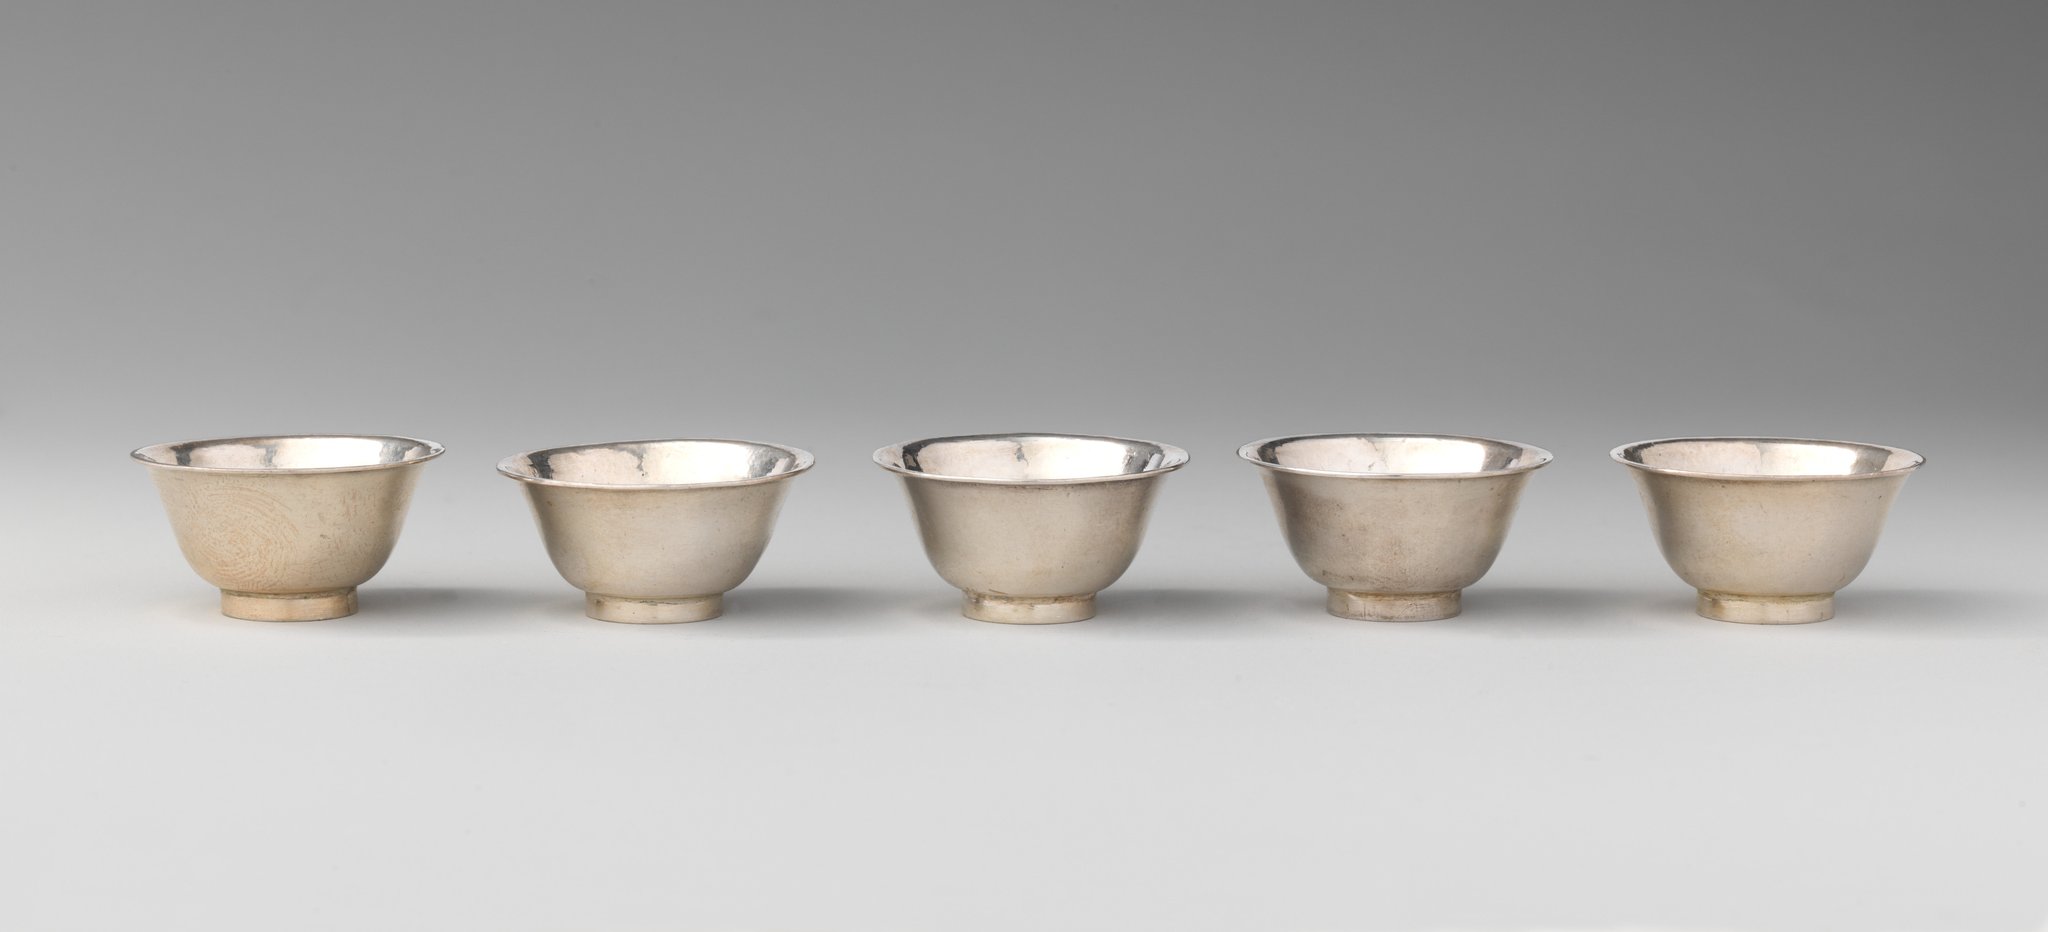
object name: cup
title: Five miniature cups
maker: david clayton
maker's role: artist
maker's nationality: british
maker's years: 1659-1719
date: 1720-1730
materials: silver